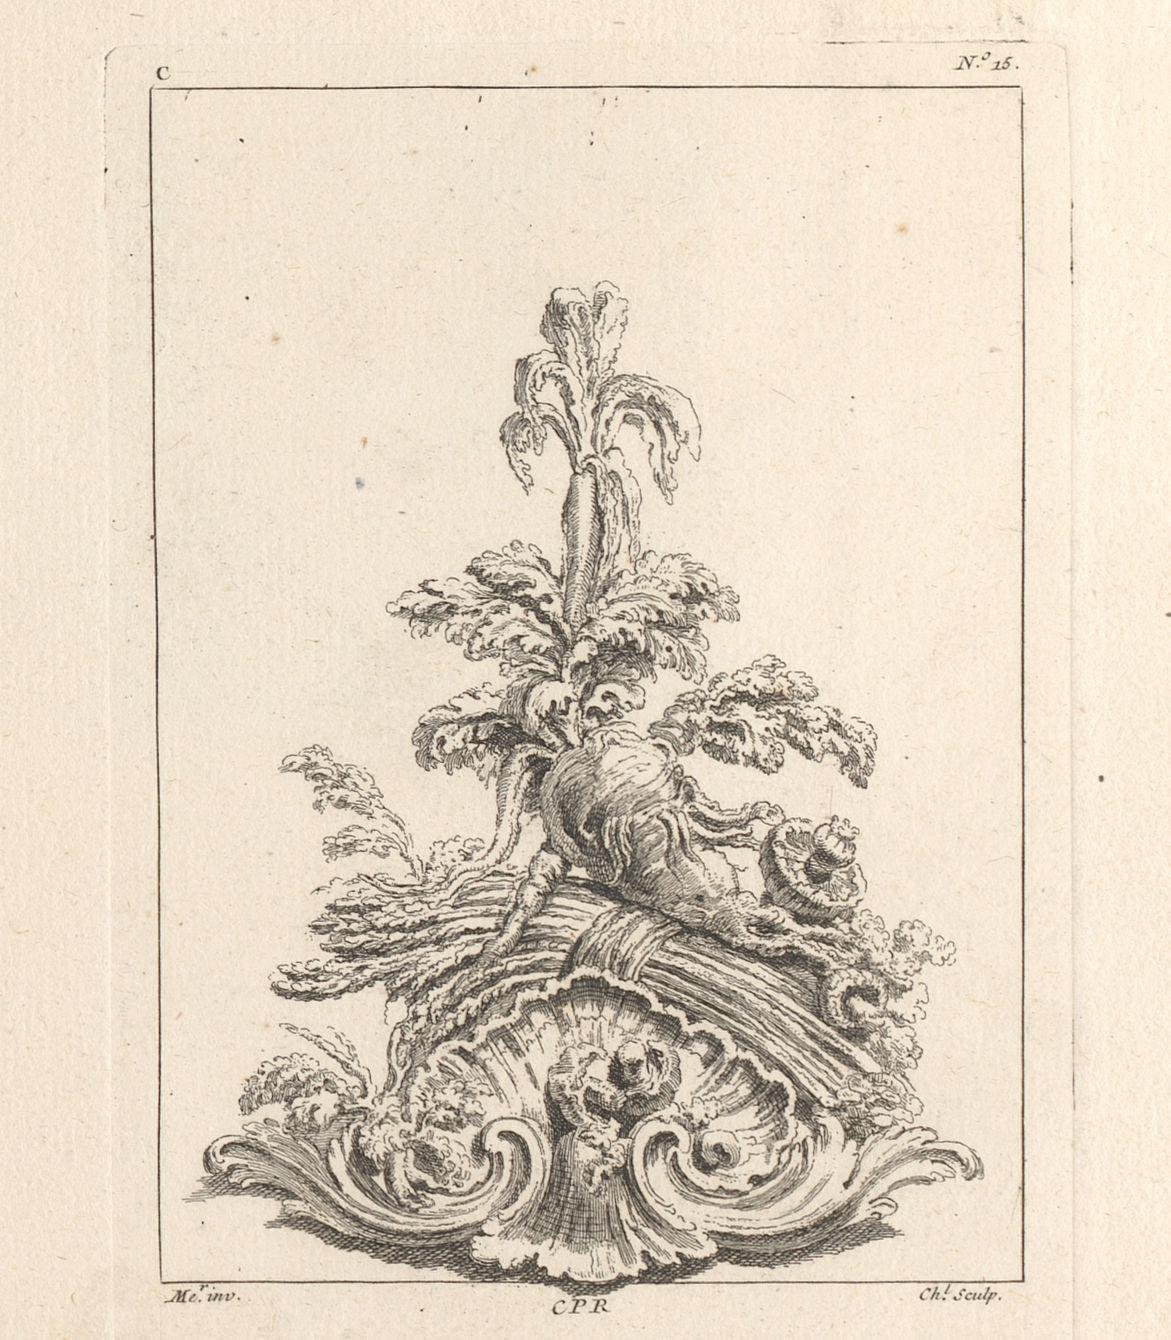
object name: album leaf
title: Oeuvre van Juste Aurele Meissonnier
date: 1738-1749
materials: paper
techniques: etching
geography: paris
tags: vegetables, scallop, shell ~ ornament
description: Prent uit een serie van zeven ornamentprenten met soortgelijke voorstellingen. Deze serie ( 'Livre de legumes') is onderdeel van de grotere reeks die het oeuvre van Meissonnier vertoont.